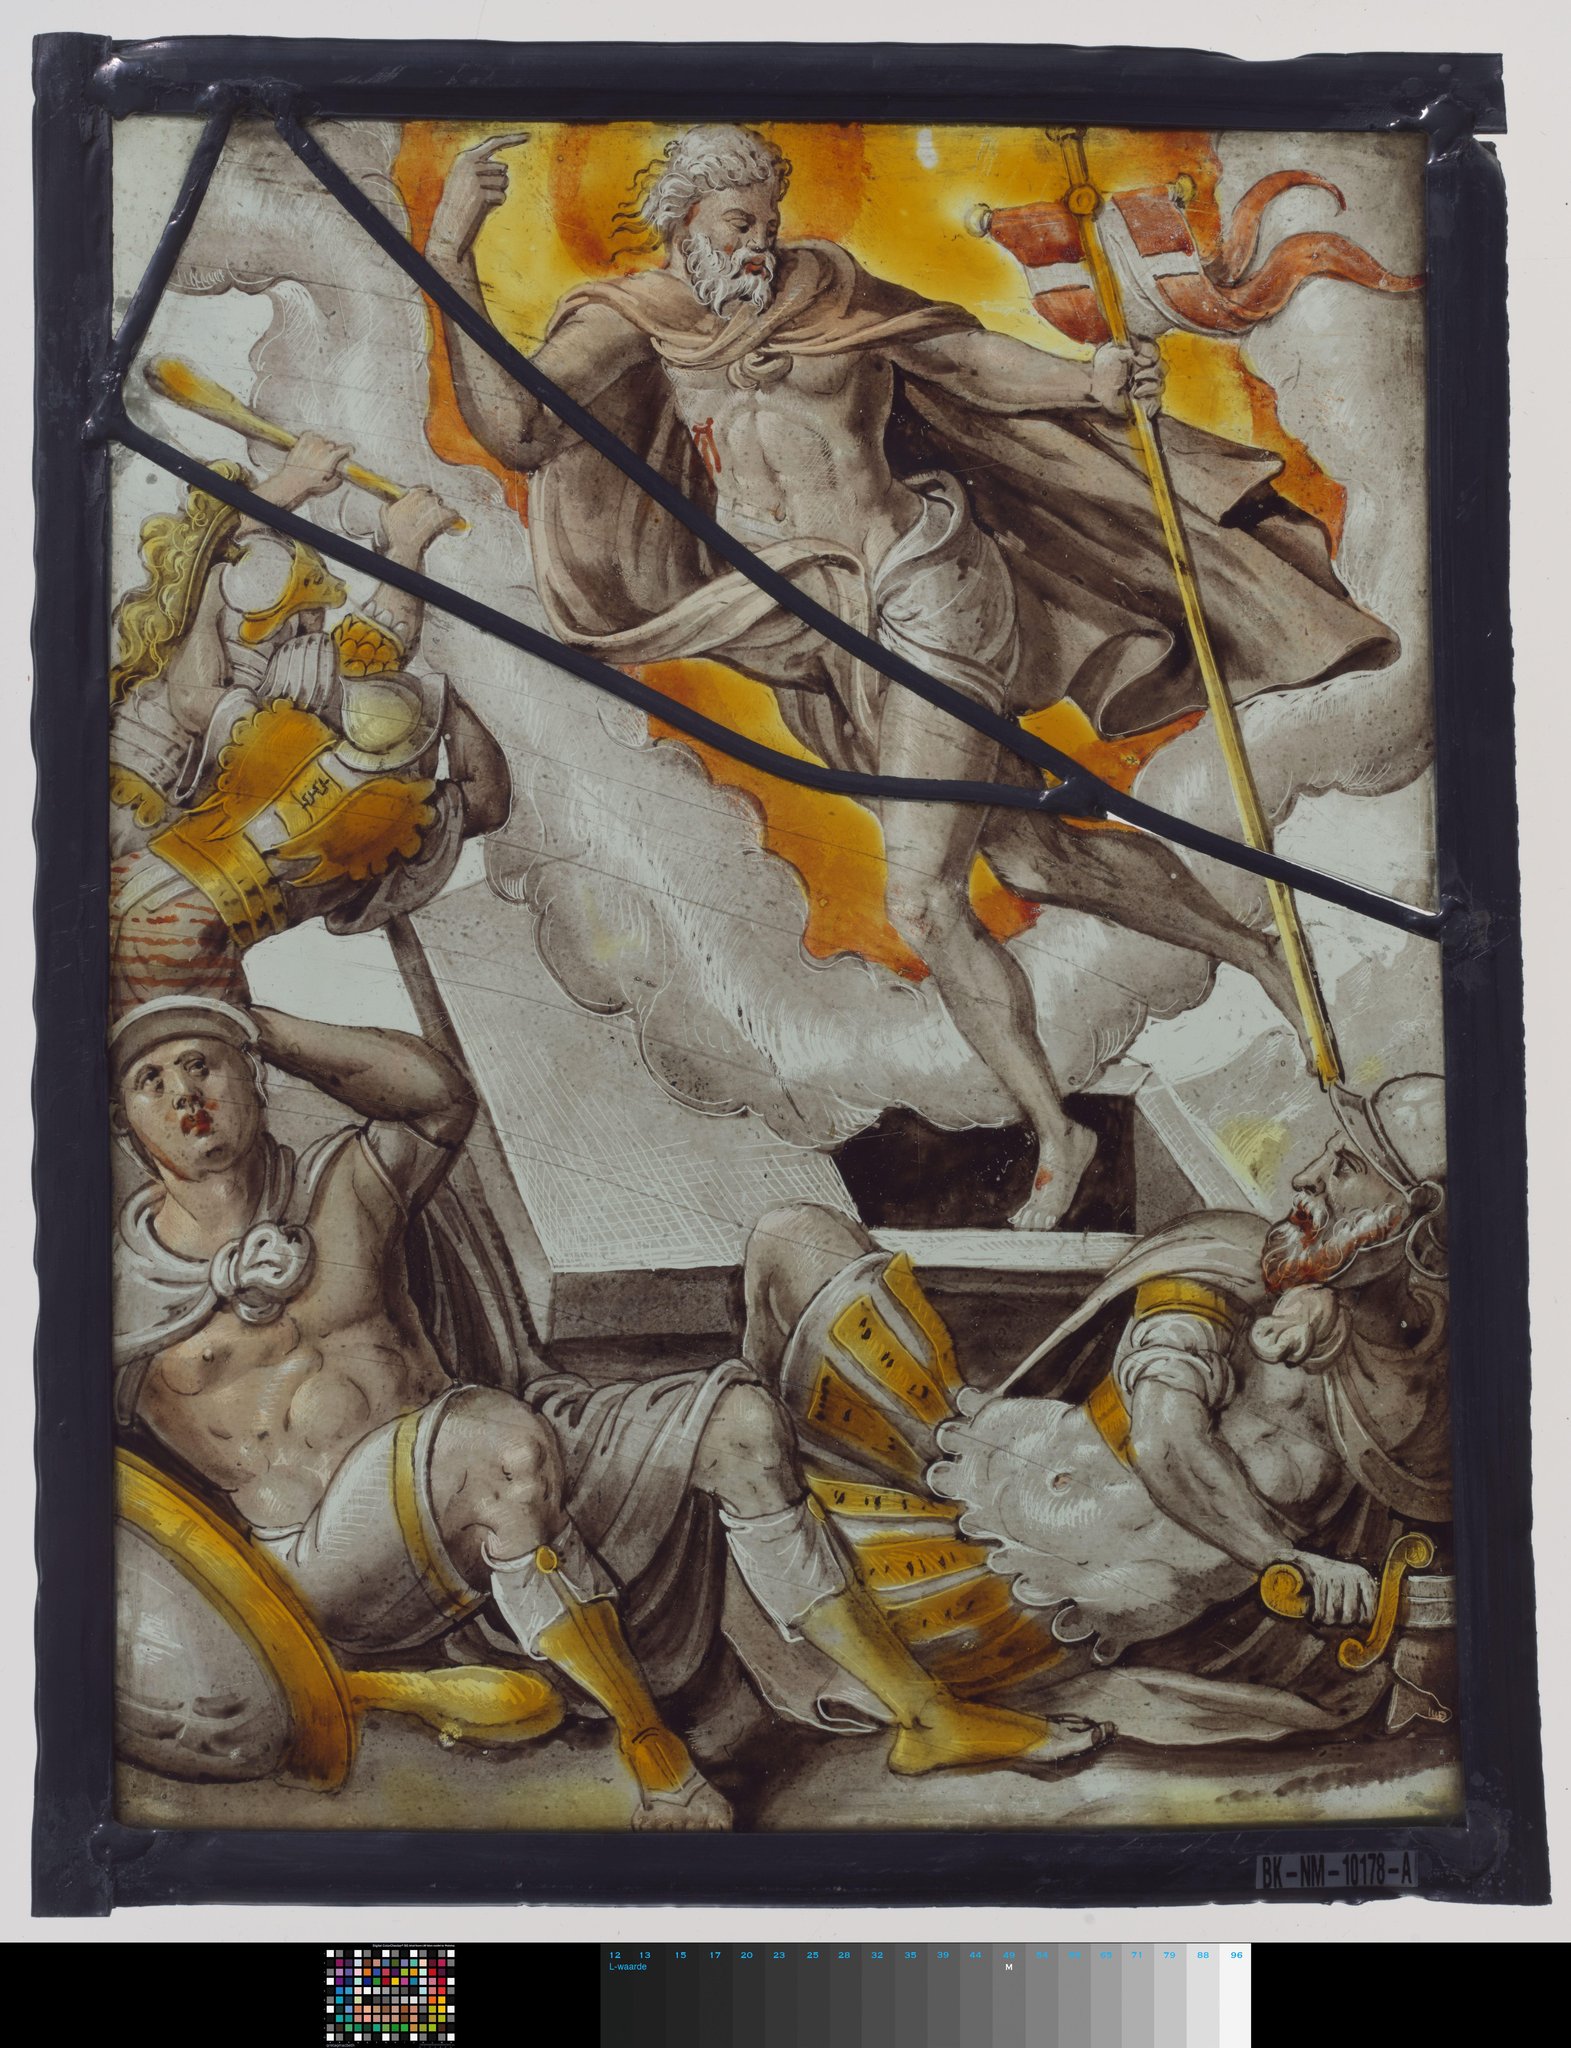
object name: light window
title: Ruit met de Opstanding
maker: Anonymous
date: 1600-1625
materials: glass, lead, pigment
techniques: leading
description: Ruit met Christus uit het graf rijzende met in de hand de rode vaan met het kruis.